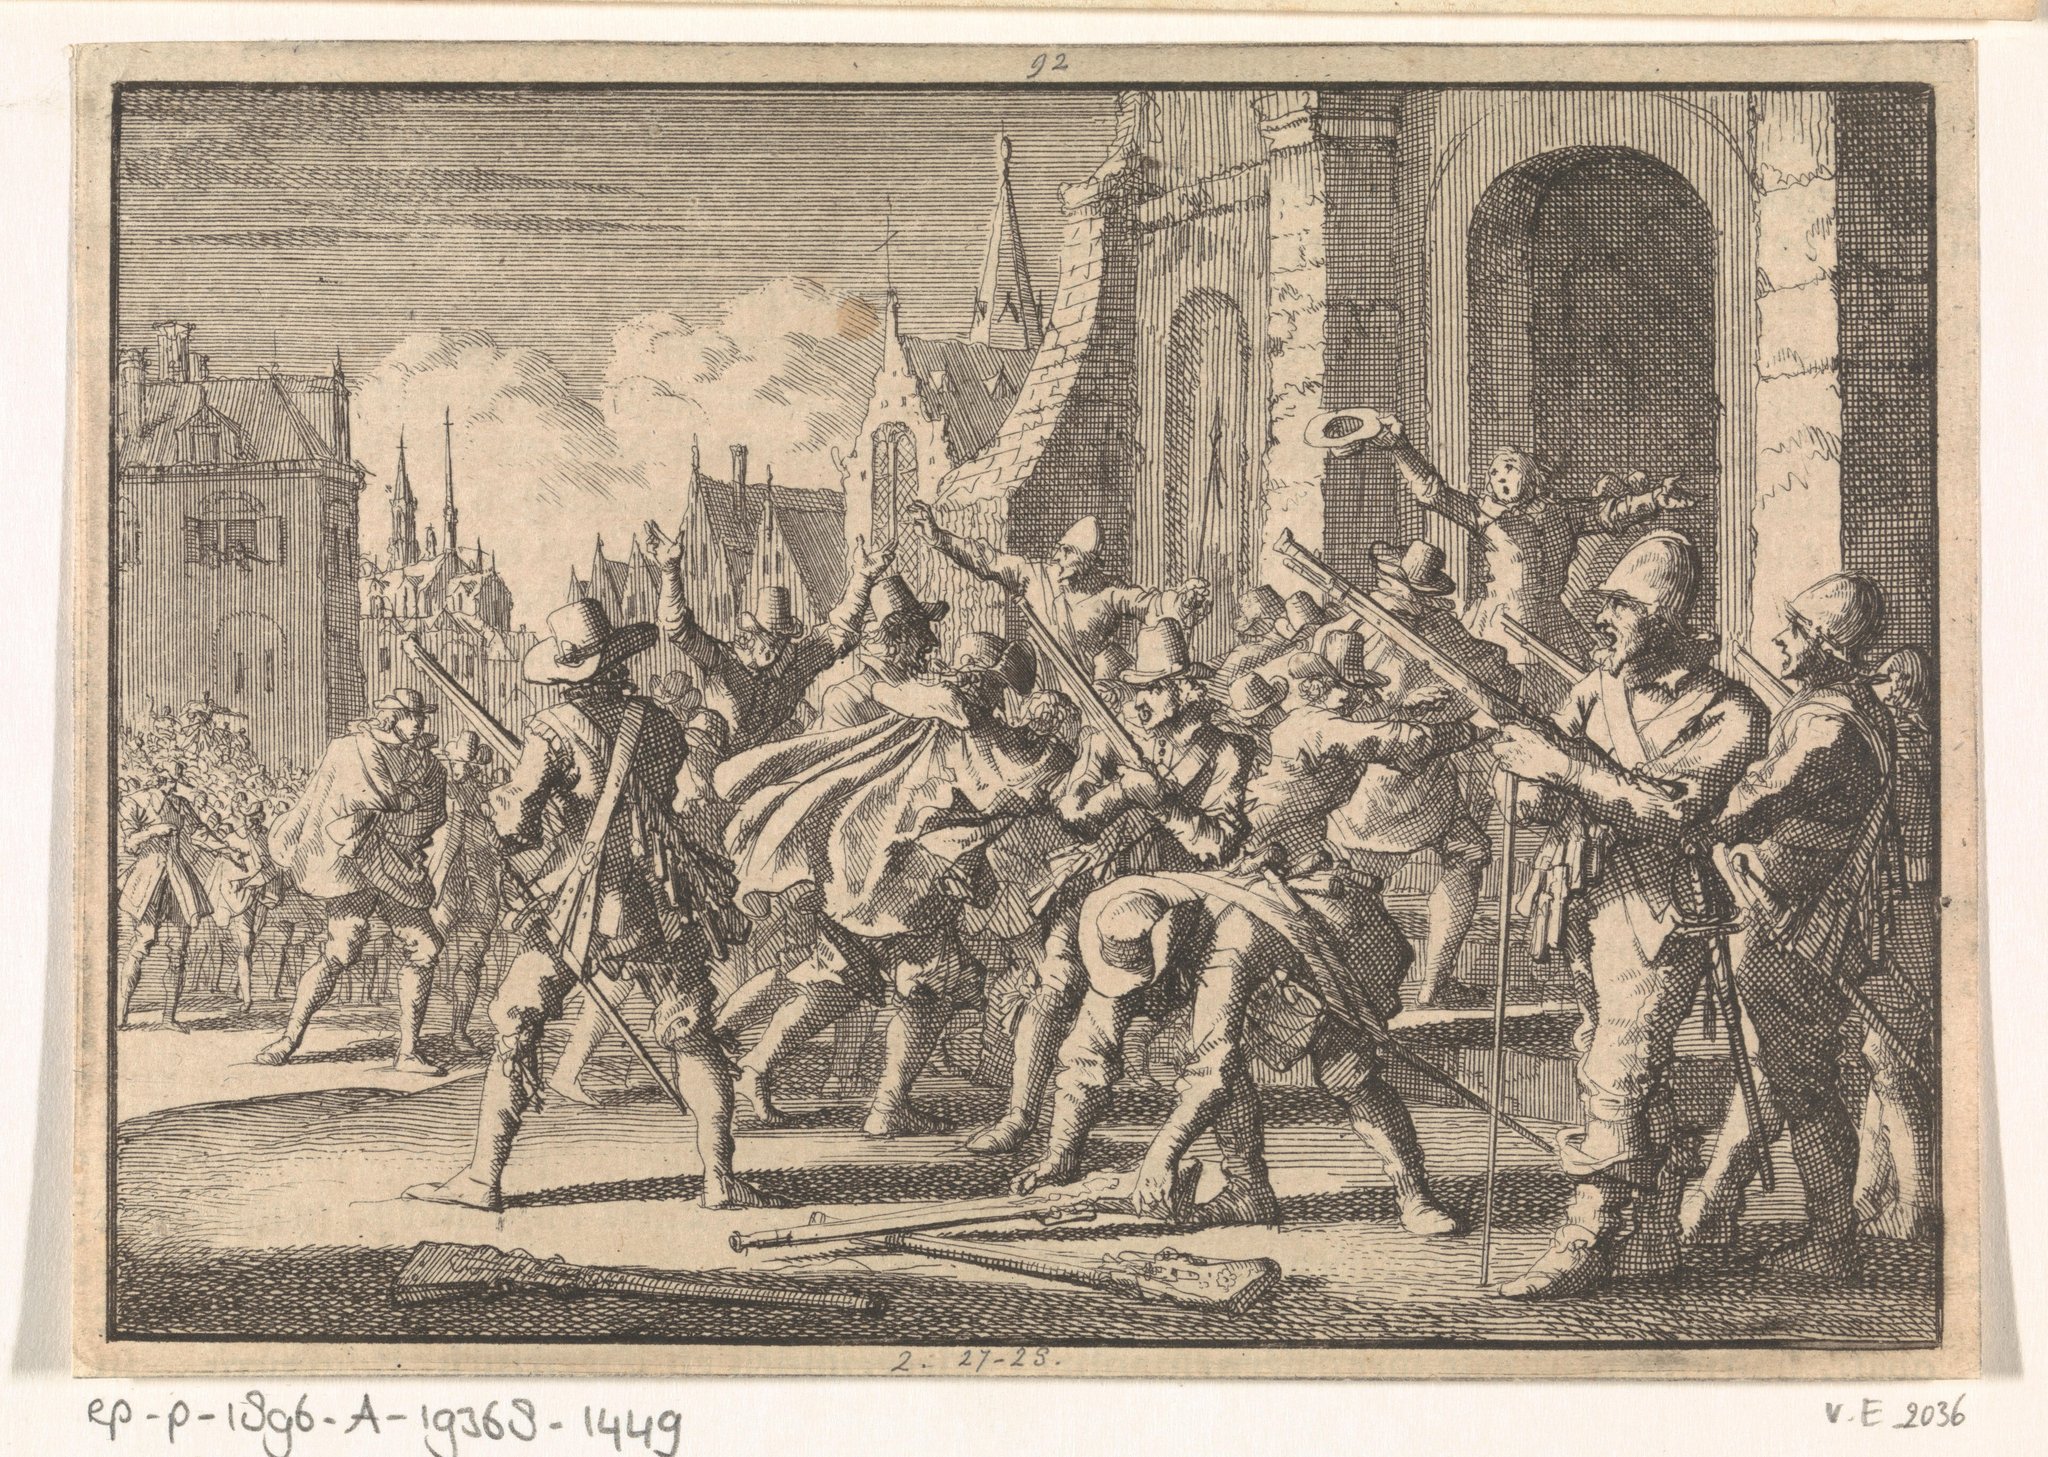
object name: print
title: Te Bremen dringen Luthersen tegen het verbod van de raad de Dom binnen terwijl de wacht de wapens neerlegt, 1638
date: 1698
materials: paper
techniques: etching, letterpress printing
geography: amsterdam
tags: church (exterior), battle, fighting in general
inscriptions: collector's mark: Lugt 2228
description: Illustratie uit: Gottfried, Johann Ludwig. Historische kronyck; vervattende een (...) beschrijvingh der aldergedenckwaerdigste geschiedenissen des weerelds, van den aenvangh der scheppingh tot (...) 1576 (2 delen). Leiden: Pieter van der Aa, 1698, dl. II, p. 27.